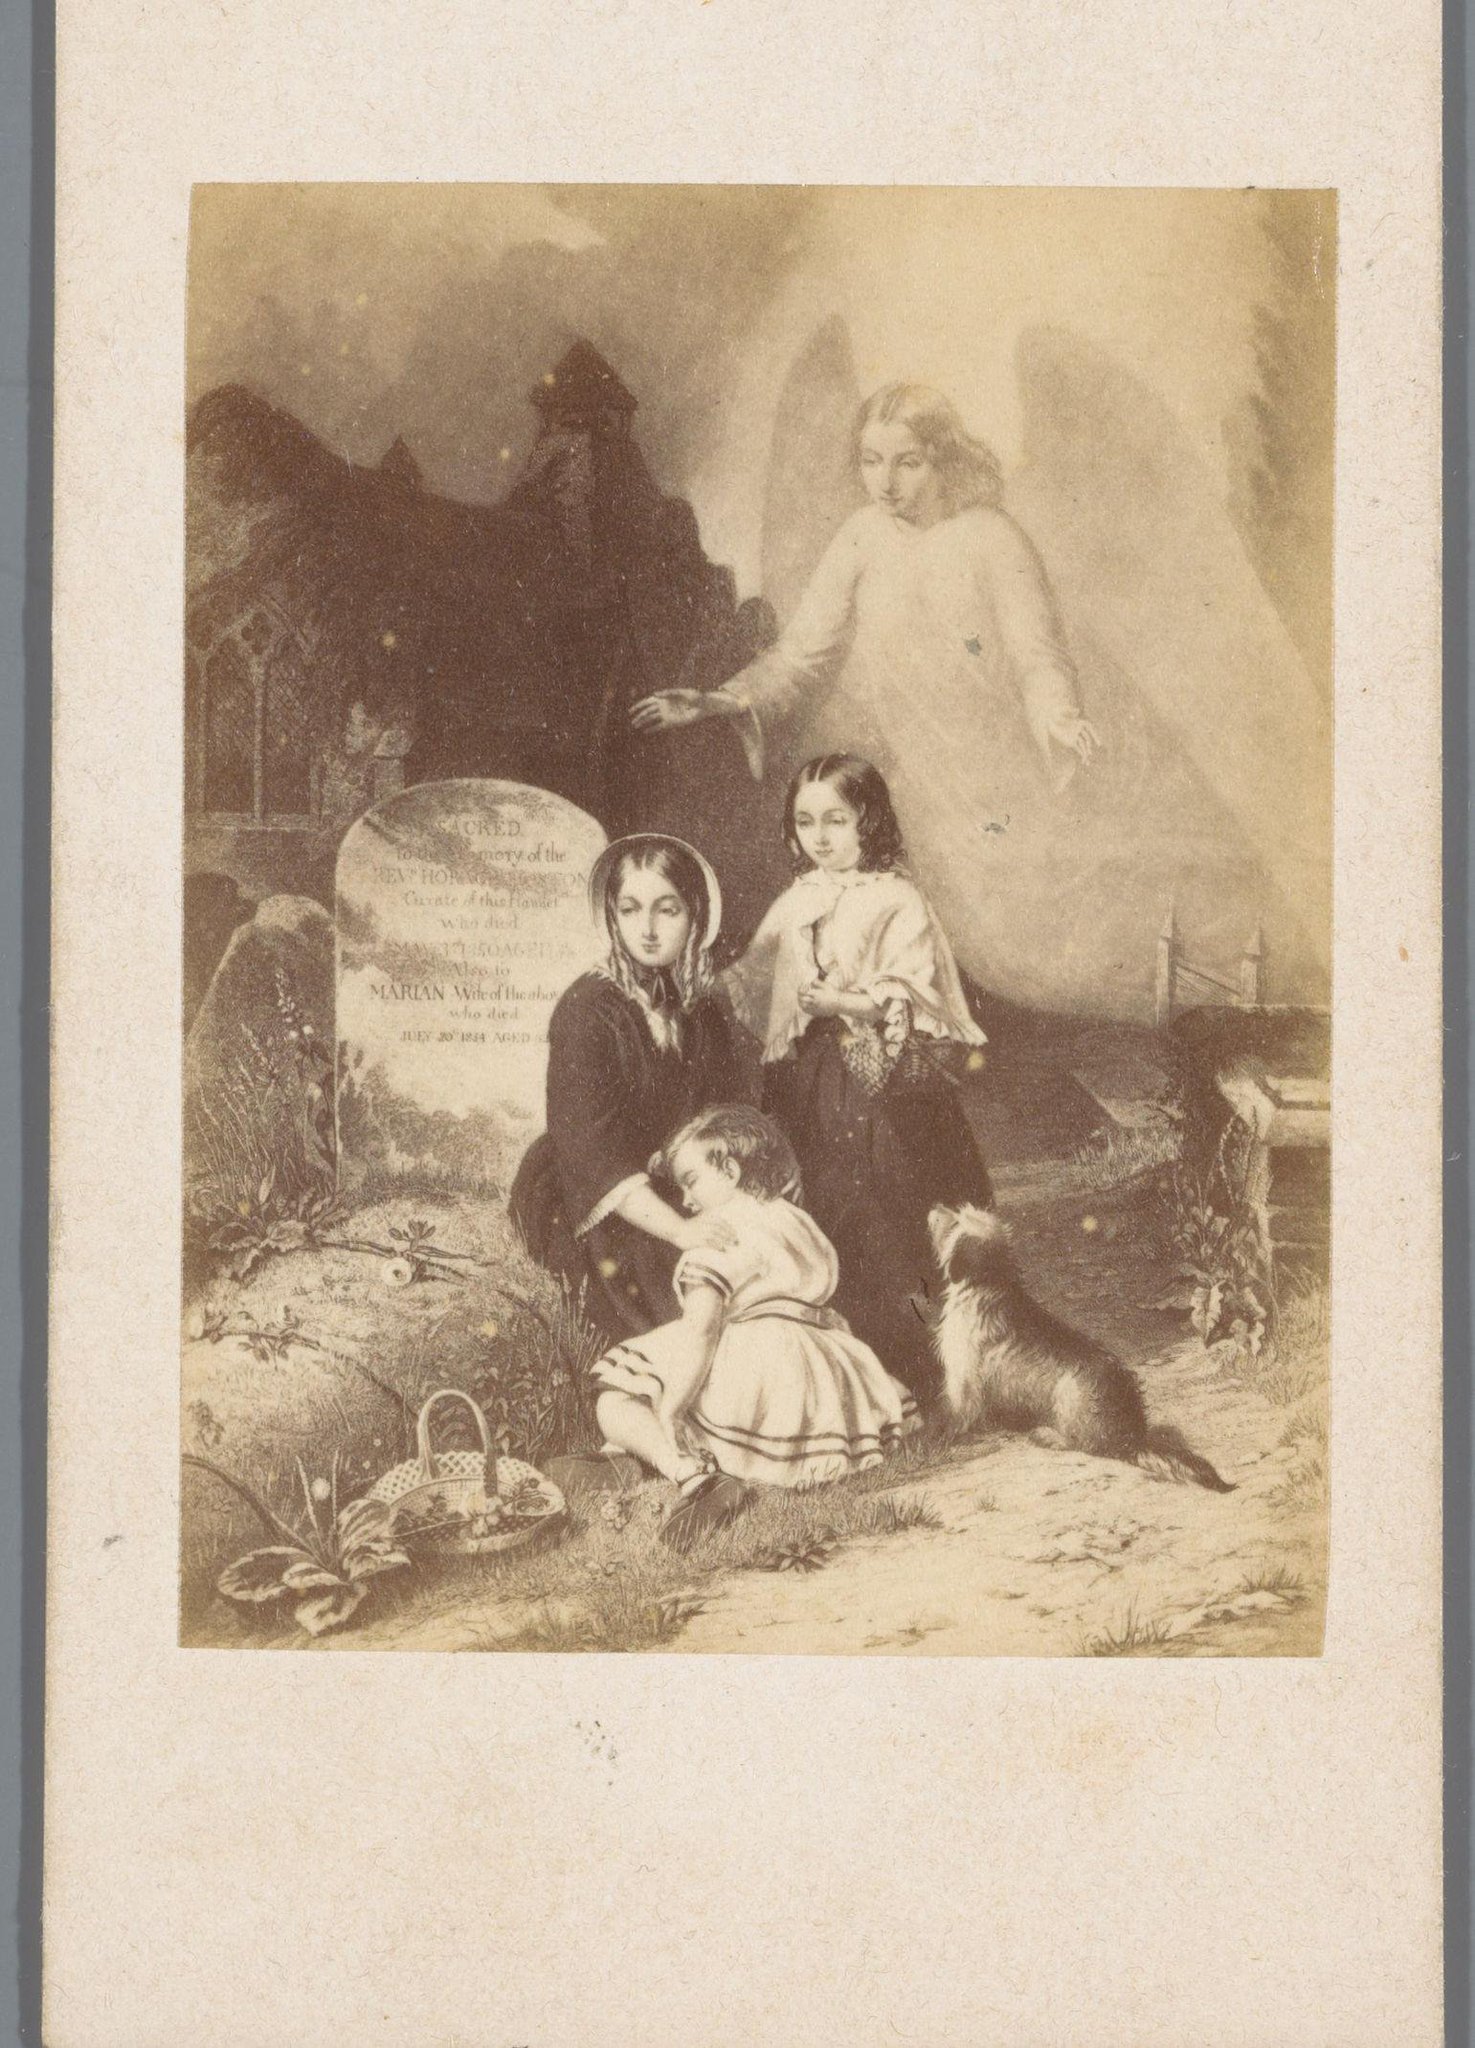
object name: carte de visite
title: Fotoreproductie van een schilderij naar het gedicht Bij moeders graf door J.J.L. ten Kate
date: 1850-1900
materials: cardboard, photographic support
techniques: albumen print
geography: amsterdam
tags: gravestone, tombstone, orphans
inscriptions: inscription: ‘BIJ MOEDERS GRAF./ (...) groote Weêrziens-vreugd!/ J. J. L. TEN KATE.’